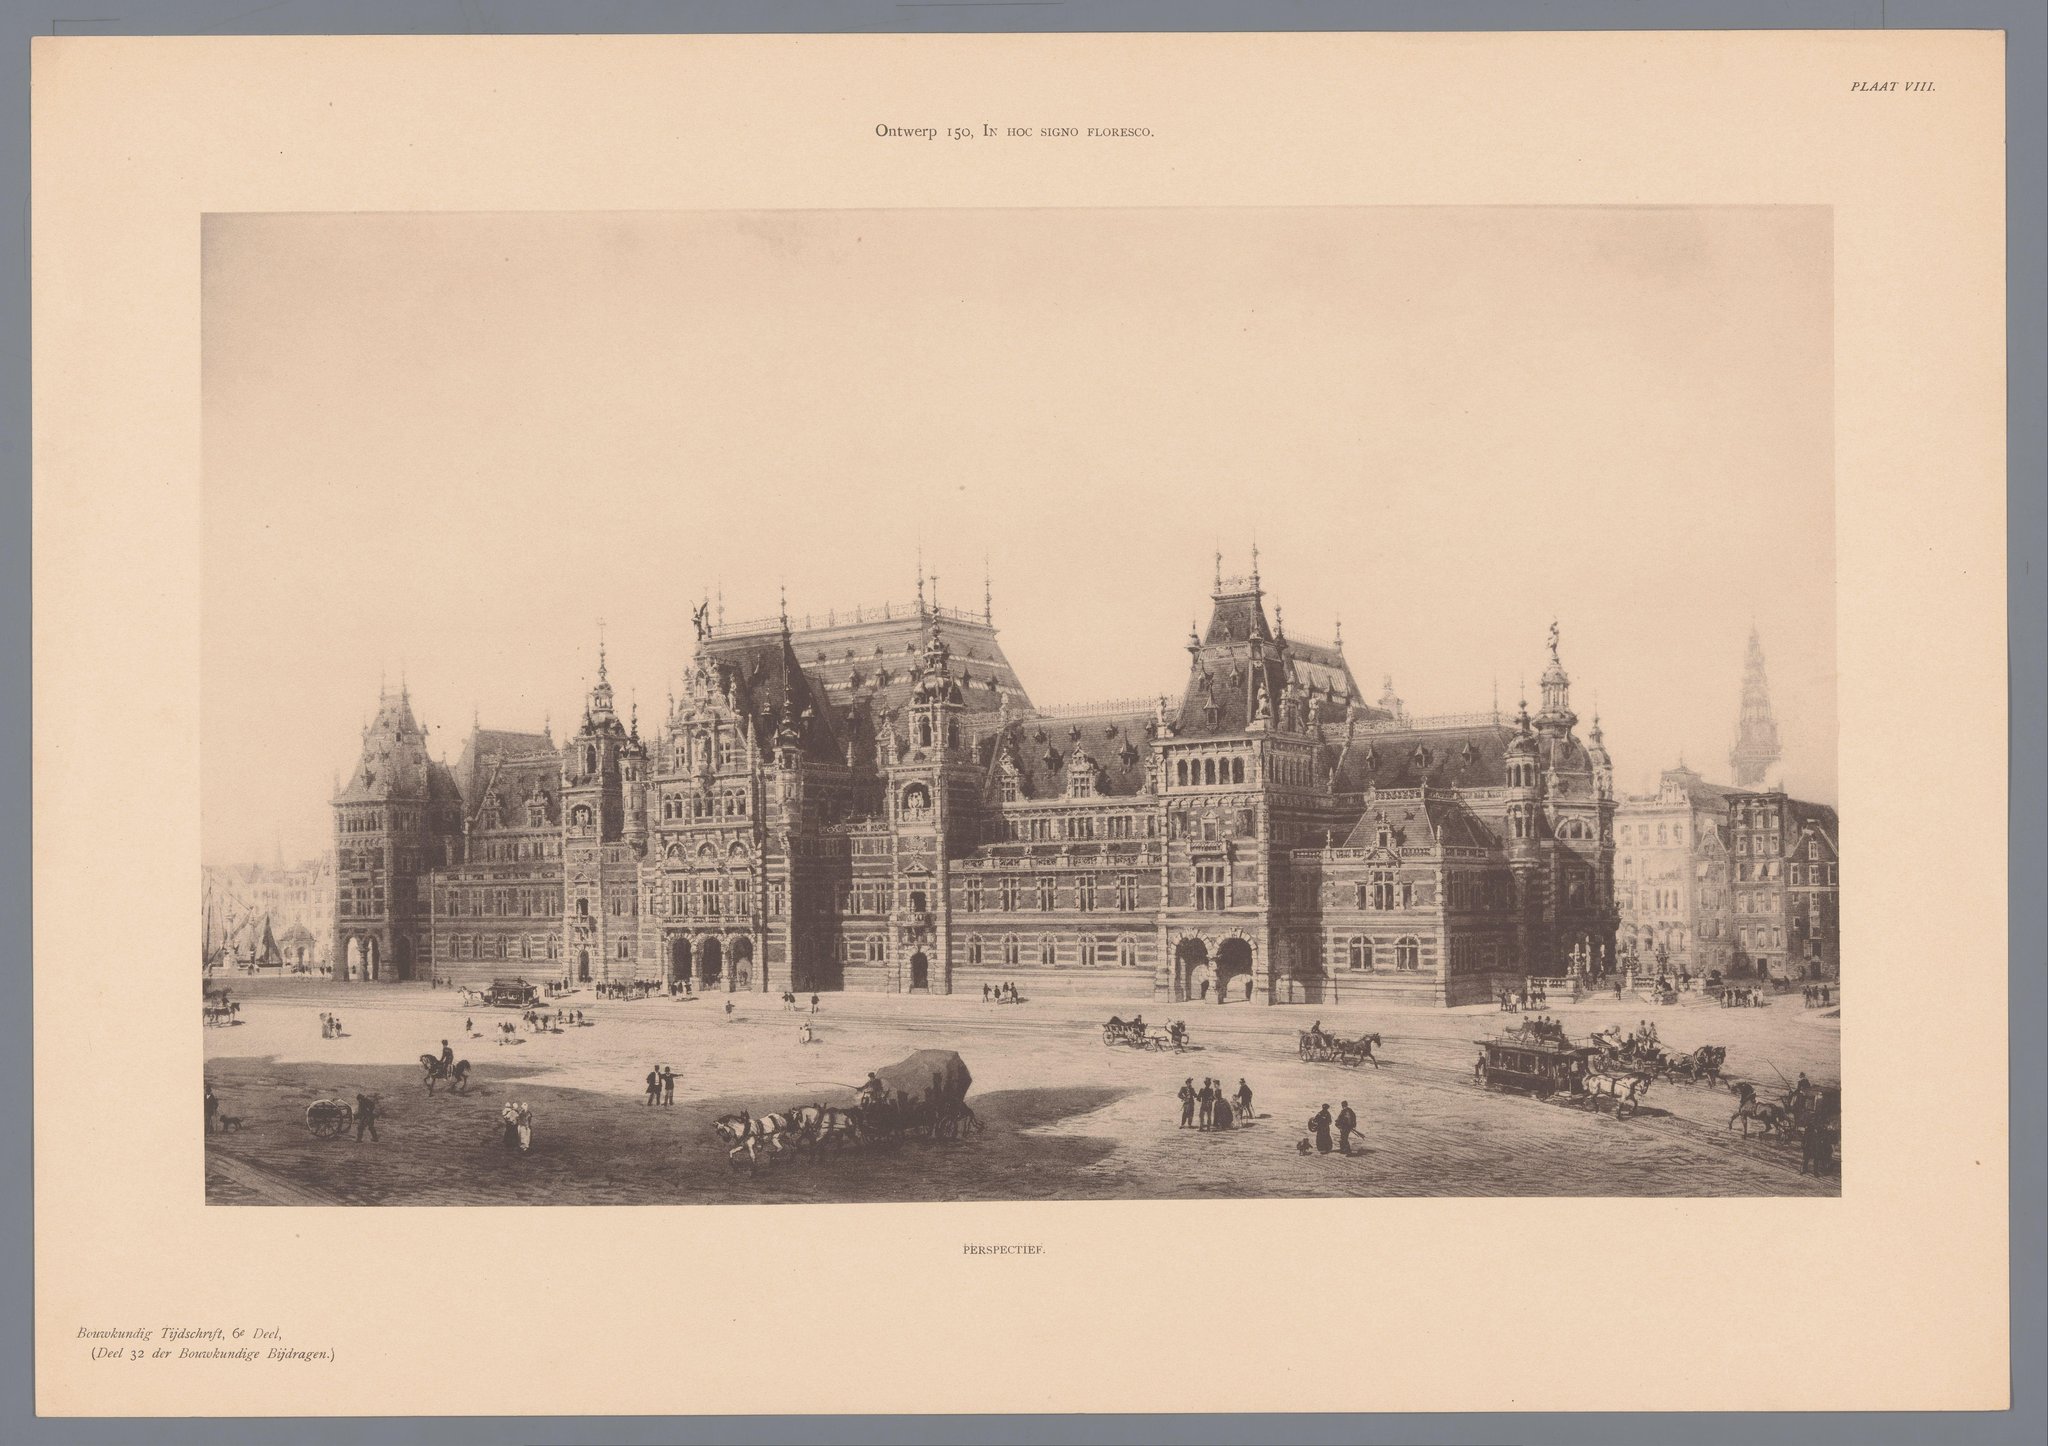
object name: book illustration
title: Ontwerp voor een nieuw beursgebouw in Amsterdam: perspectiefgezicht van ontwerp 150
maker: Anonymous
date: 1886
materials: paper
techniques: photograph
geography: amsterdam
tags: market-hall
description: Prent uit: Bouwkundig tijdschrift 6, deel 32 der bouwkundige bijdragen (1886), pl. 8.